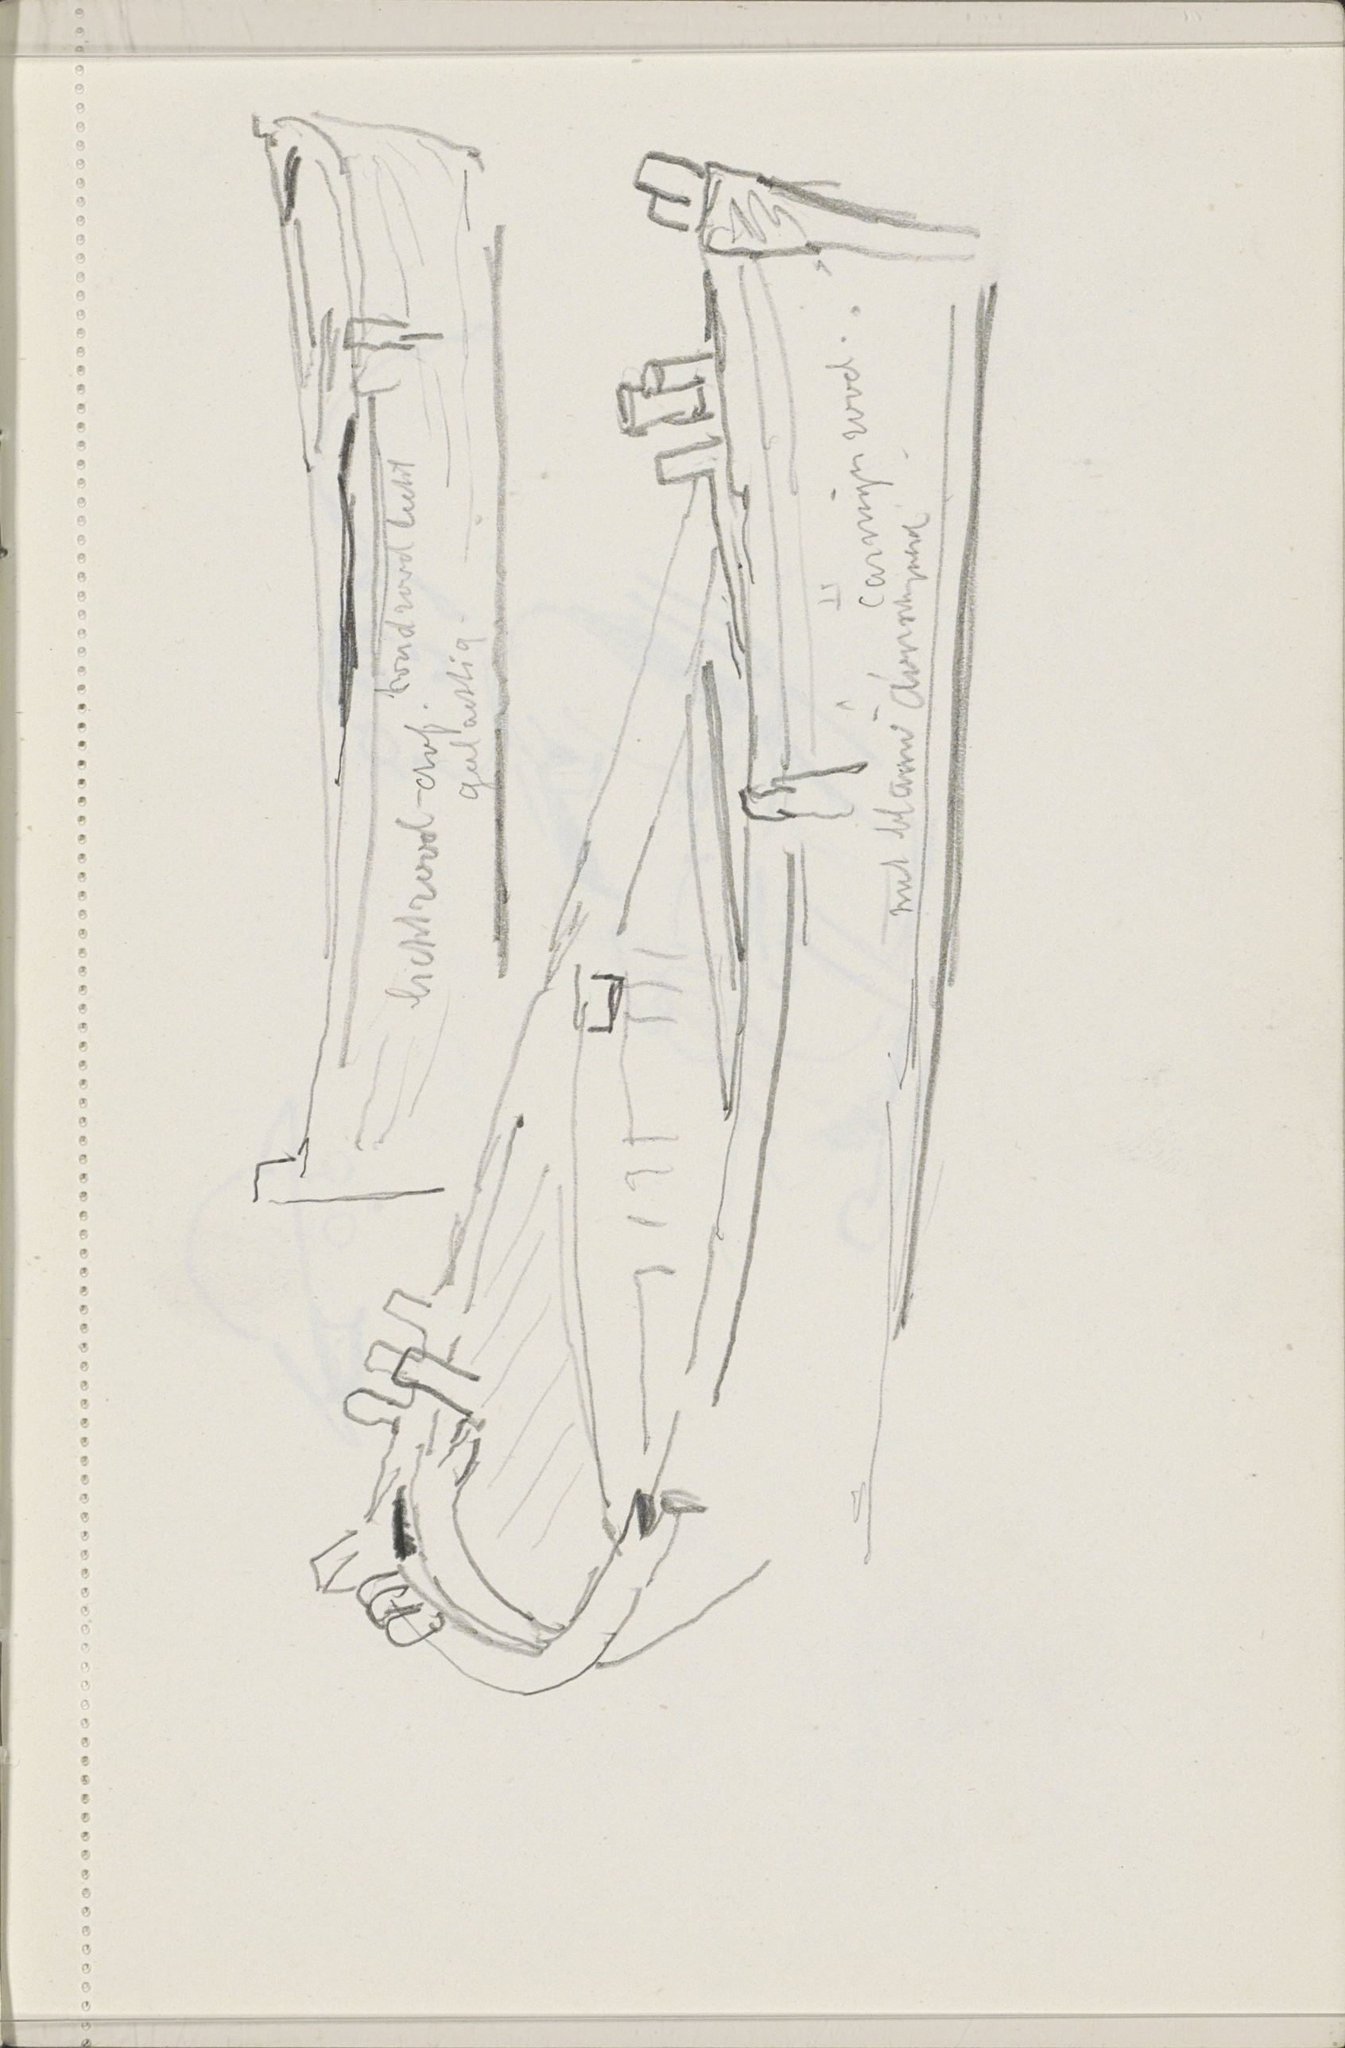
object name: sketchbook leaf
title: Twee roeiboten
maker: cornelis vreedenburgh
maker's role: draughtsman, print maker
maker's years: 1880-1946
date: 1935-1936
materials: paper, pencil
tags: rowing-boat, canoe, etc.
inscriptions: kleurnotitie, handgeschreven in potlood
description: Blad 53 recto uit een schetsboek met 73 bladen.